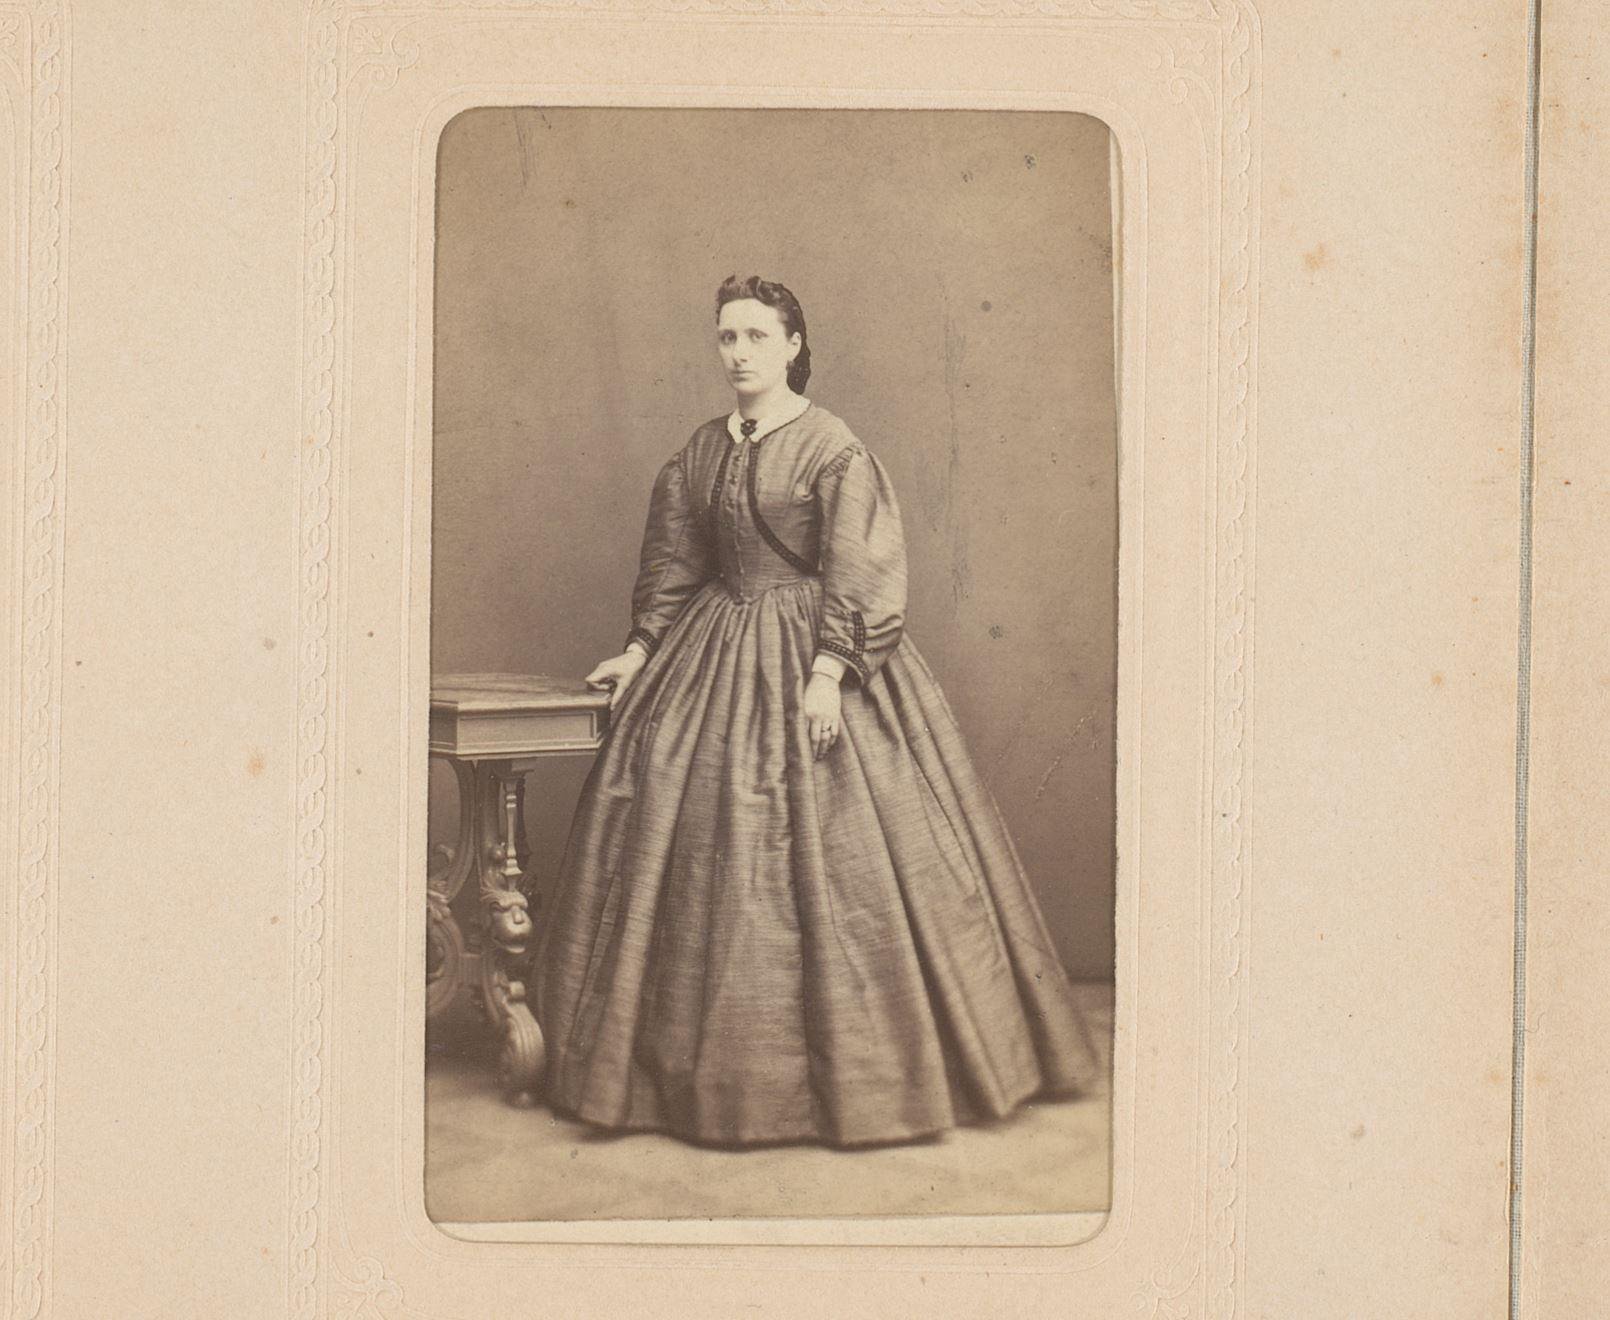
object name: carte de visite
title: Portret van een vrouw, staand bij een tafel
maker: franz seidel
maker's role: painter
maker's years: 1818-1903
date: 1860-1900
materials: cardboard, photographic support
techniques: albumen print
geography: leitmeritz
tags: historical persons - bb - woman, table, standing figure - aa - female human figure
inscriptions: inscription: ‘F. Seidel/ Maler und Photograph/ in/ LEITMERITZ.’, name: ‘[...]k[.] [.] Lo[..]’, annotation: ‘AK’